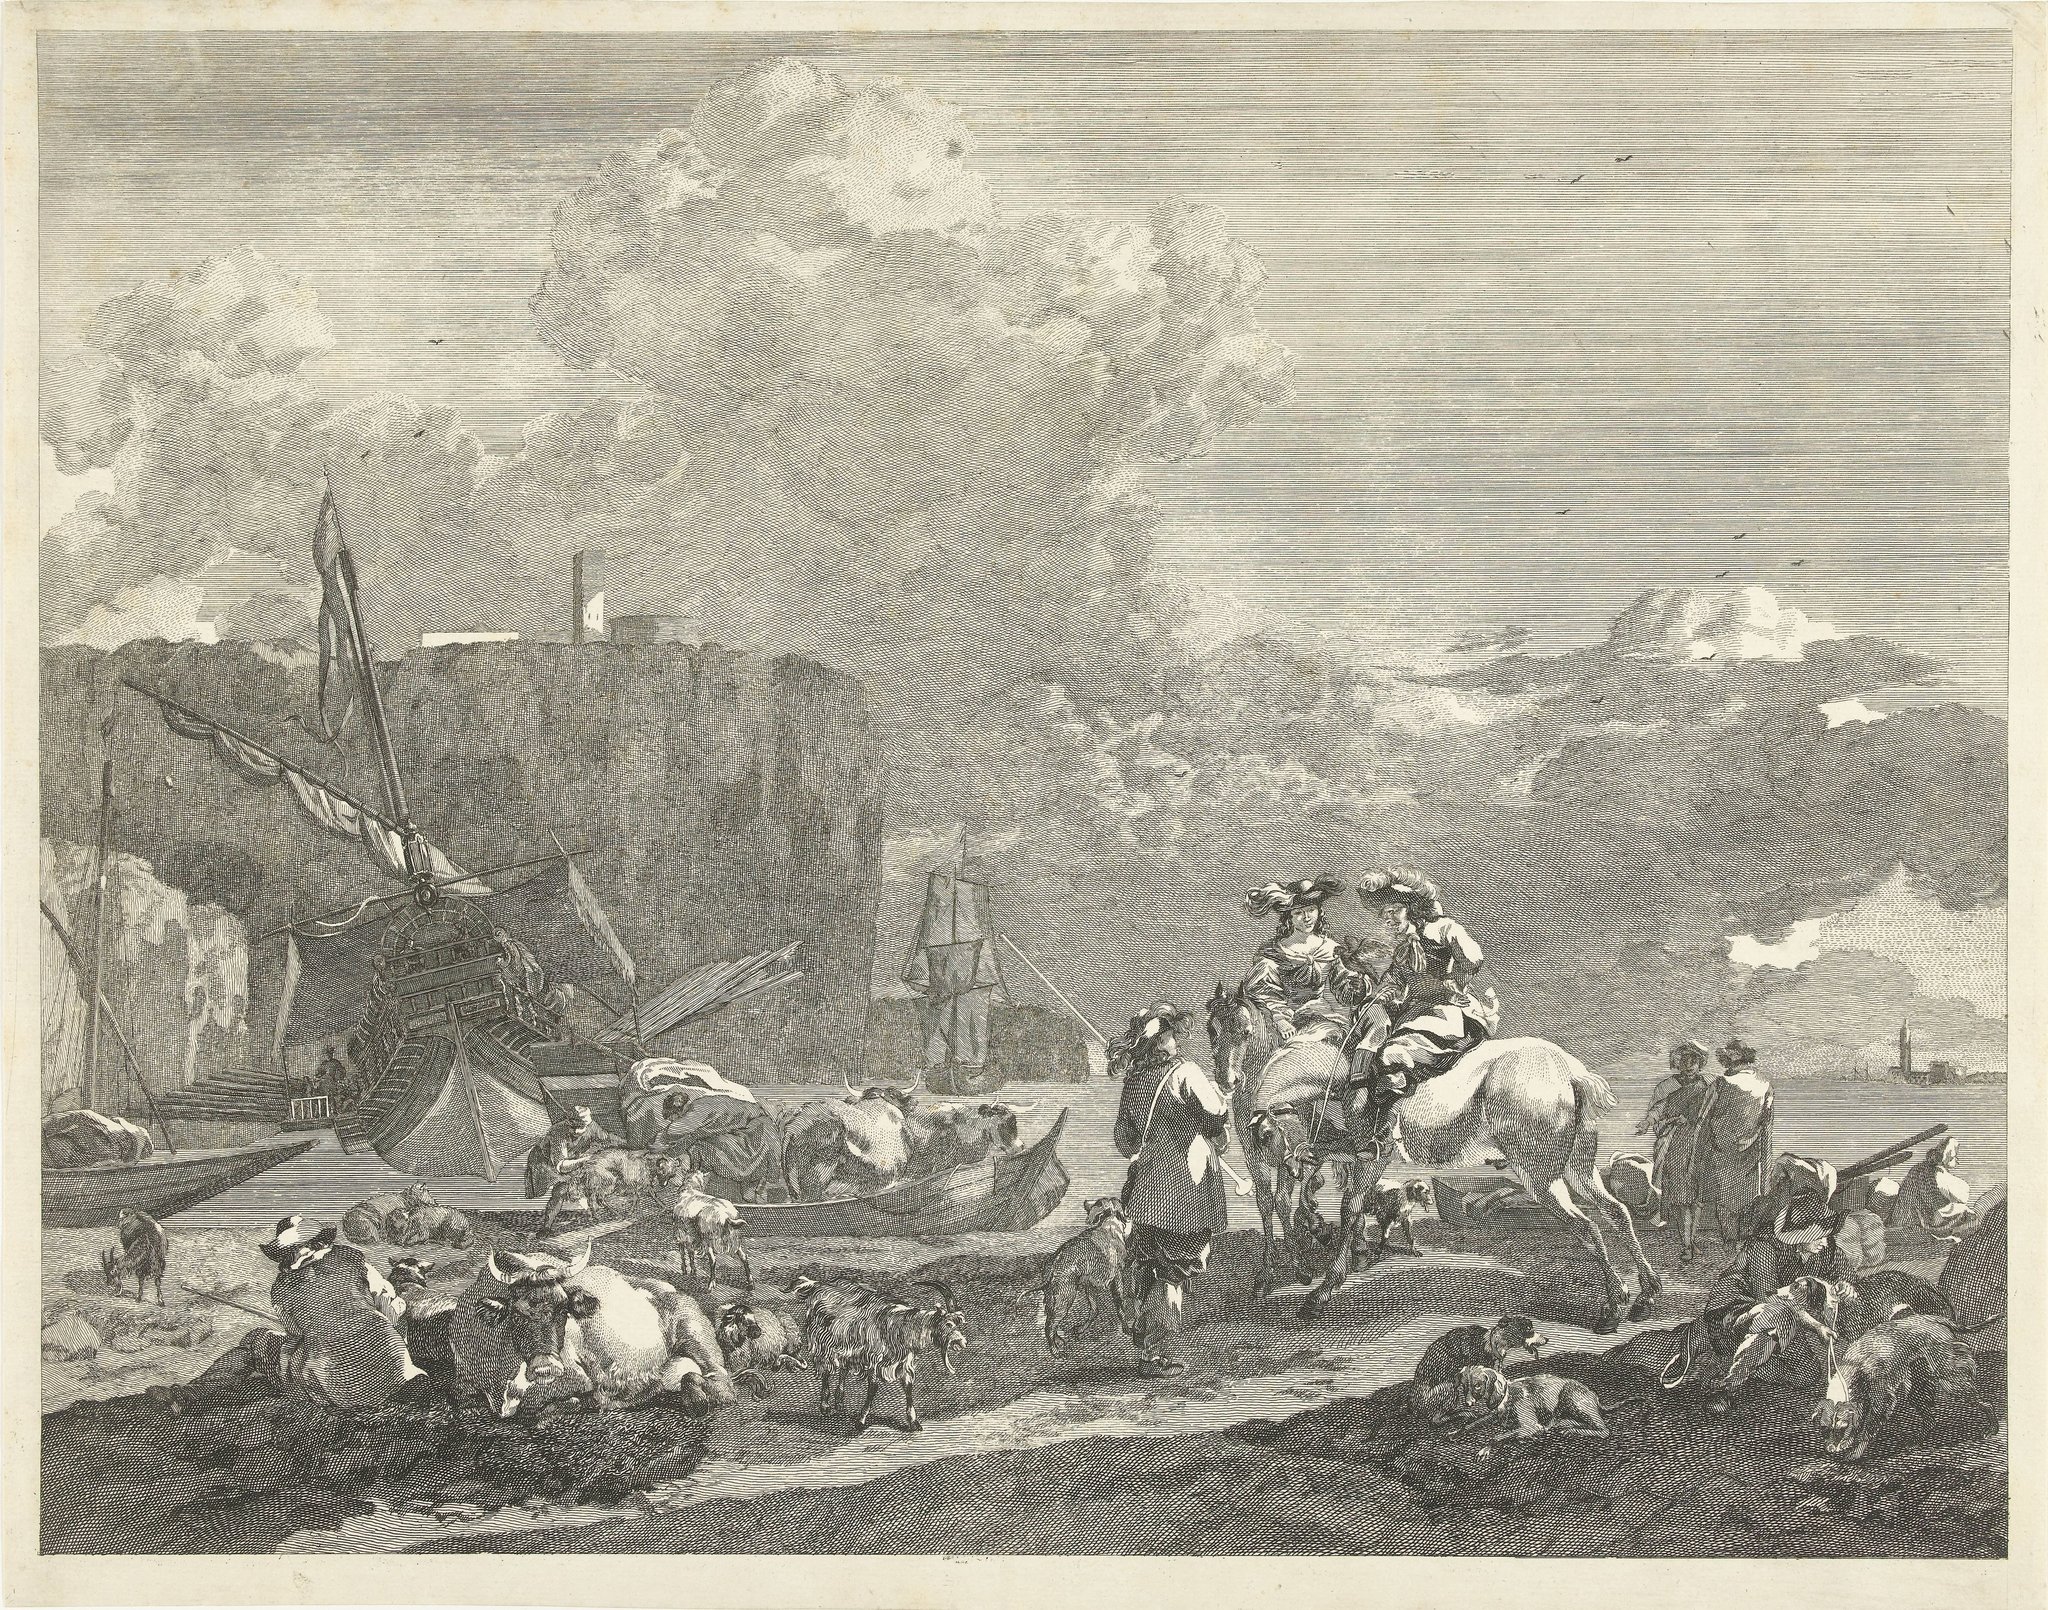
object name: print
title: Havengezicht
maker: abraham delfos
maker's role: draughtsman, painter, print maker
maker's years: 1731-1820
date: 1741-1820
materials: paper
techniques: etching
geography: leiden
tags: harbour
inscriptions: collector's mark: Lugt 240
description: Havengezicht met elegant paar te paard in gesprek met een man, handelaren laden en lossen schepen bij een rotskust.